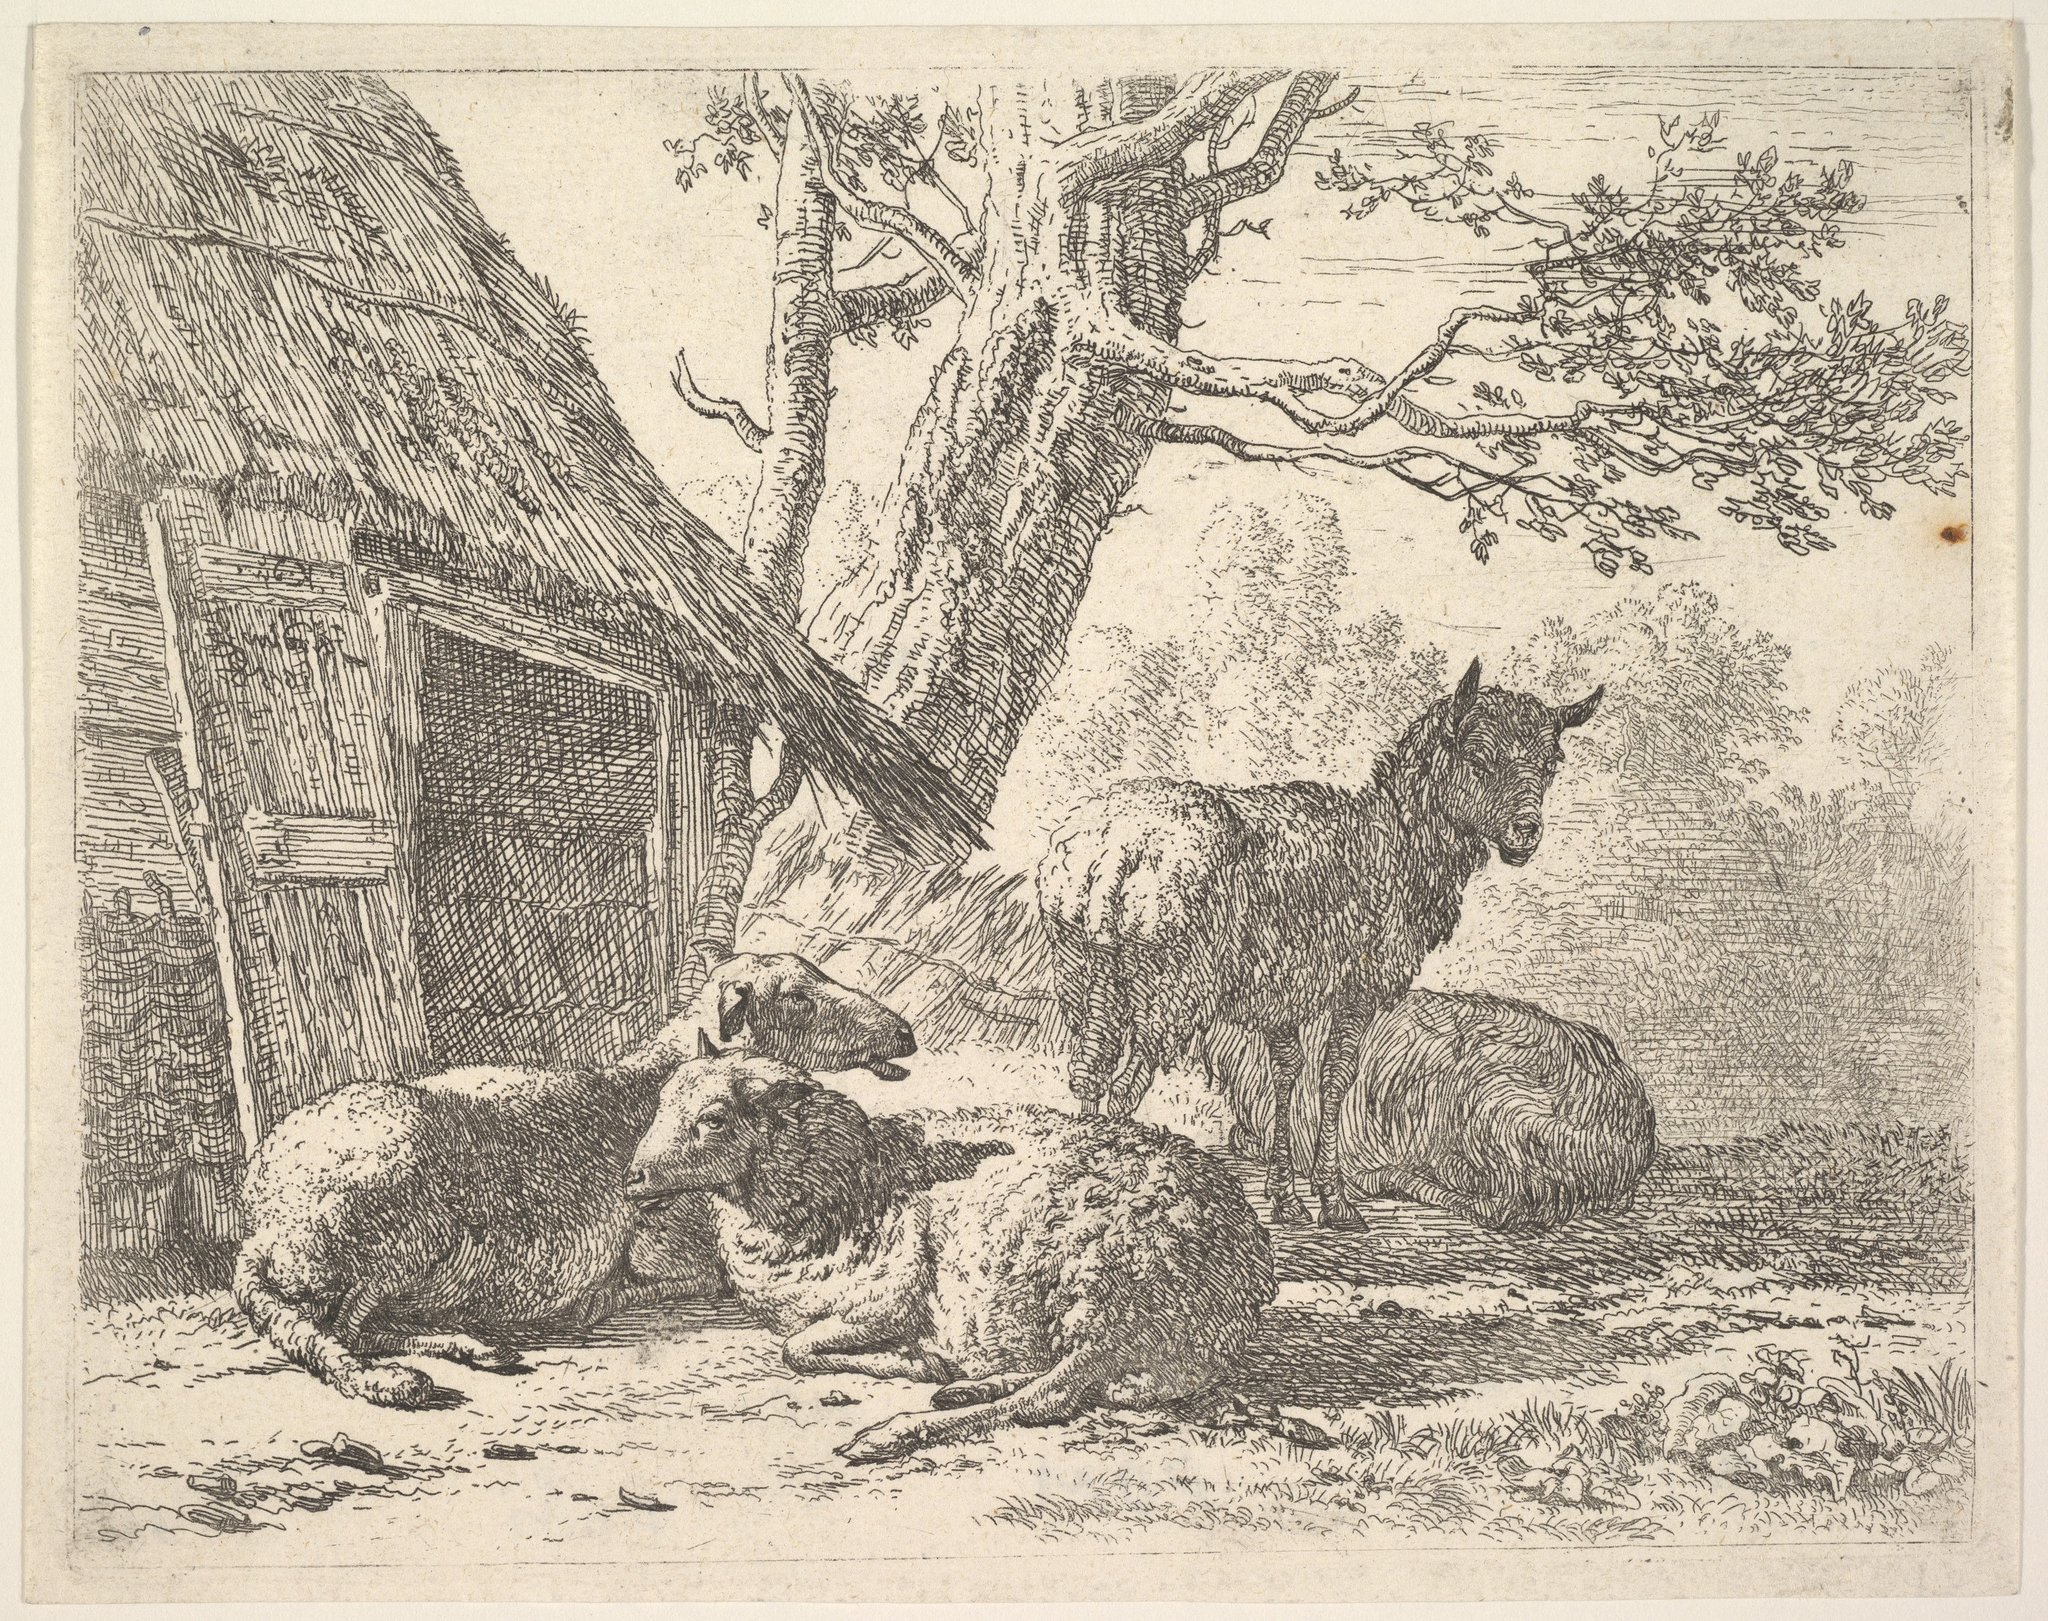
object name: print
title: Four sheep, one sheep stands among three others lying on the ground next to a shed with thatched roof and open door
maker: karel dujardin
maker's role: artist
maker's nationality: dutch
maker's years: 1622-1678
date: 1658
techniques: etching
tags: sheep,trees